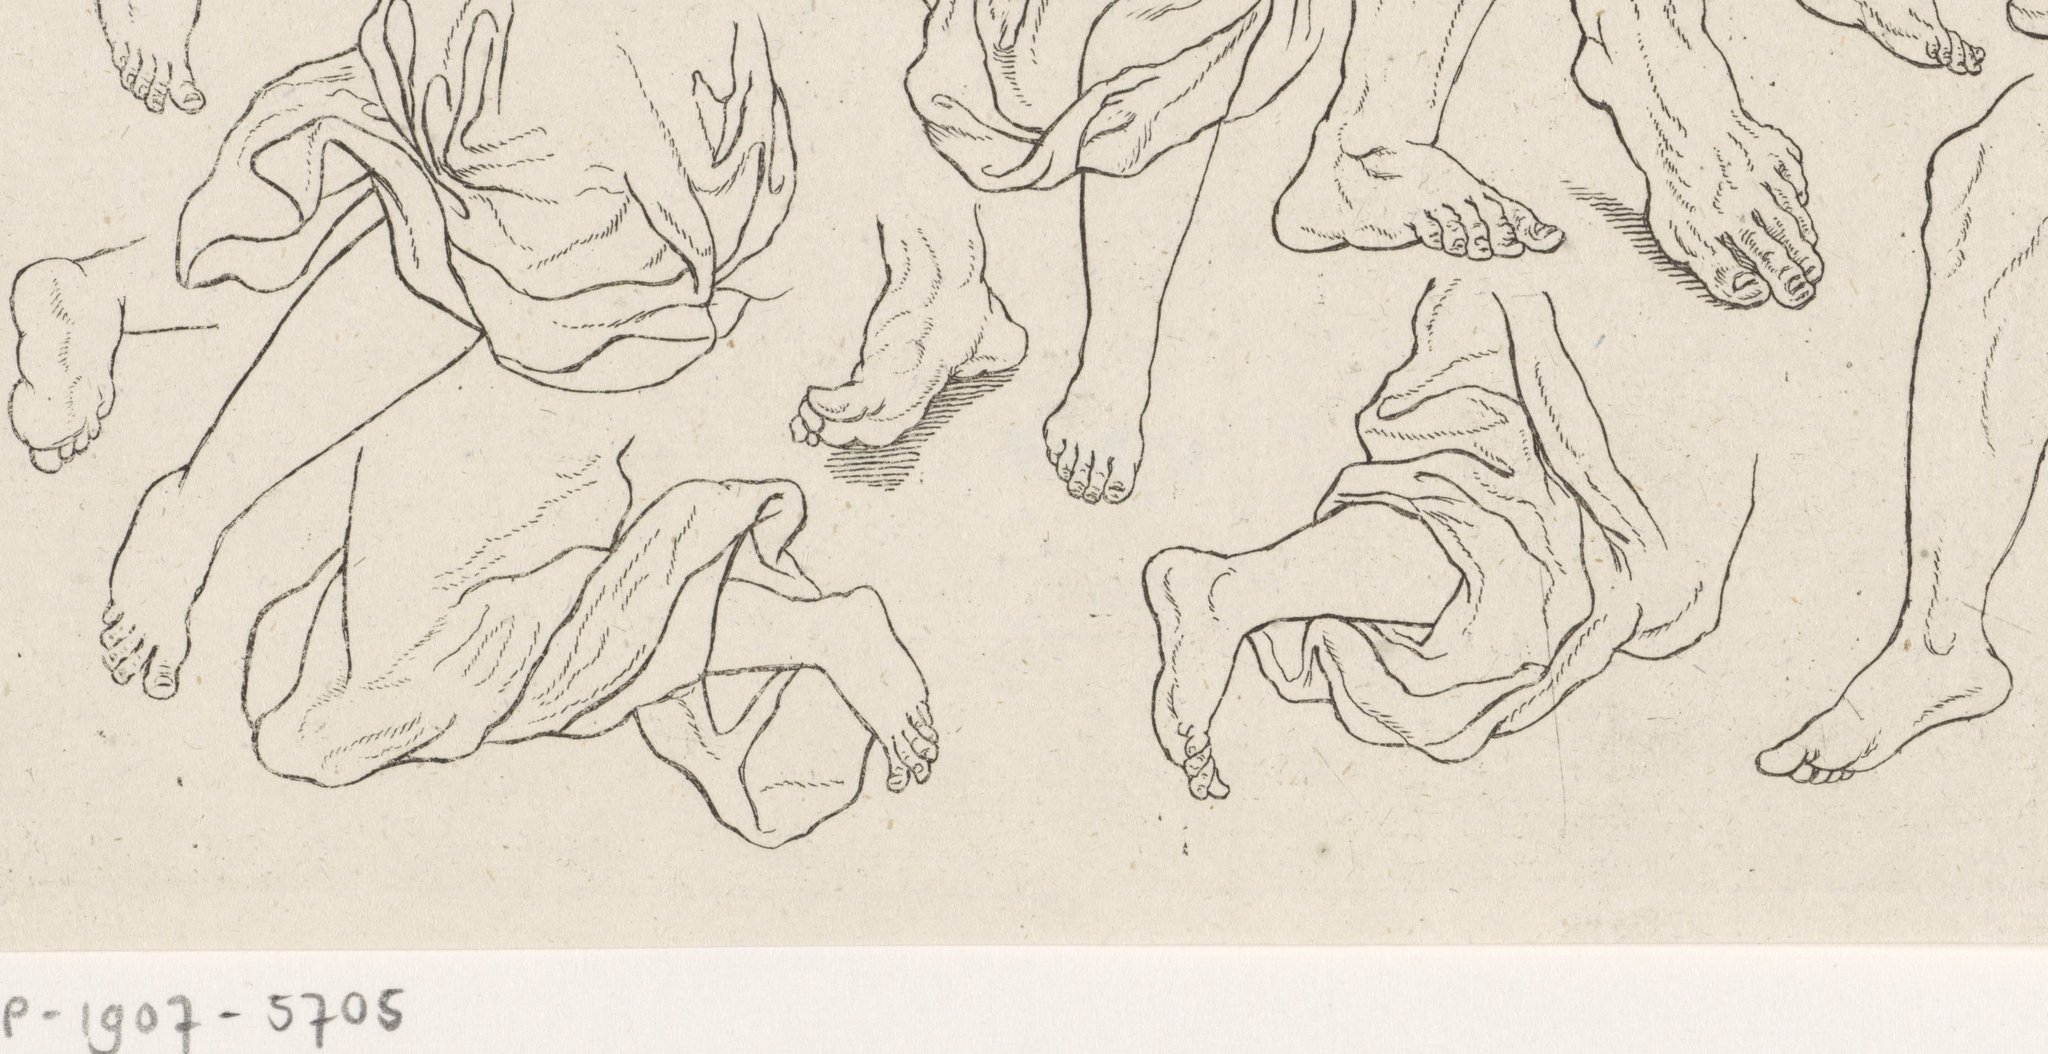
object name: print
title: Principe de dessein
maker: leonard schenk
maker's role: print maker, publisher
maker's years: 1696-1767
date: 1710-1767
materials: paper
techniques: etching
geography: amsterdam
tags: lower leg, legs - aa - female human figure, legs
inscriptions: collector's mark: Lugt 2228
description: Verschillende aanzichten van vrouwelijke en mannelijke benen of delen daarvan, voornamelijk van onderbenen. Sommige benen zijn naakt. De prent is afkomstig uit een serie van vermoedelijk twaalf studievoorbeelden voor jonge kunstenaars.